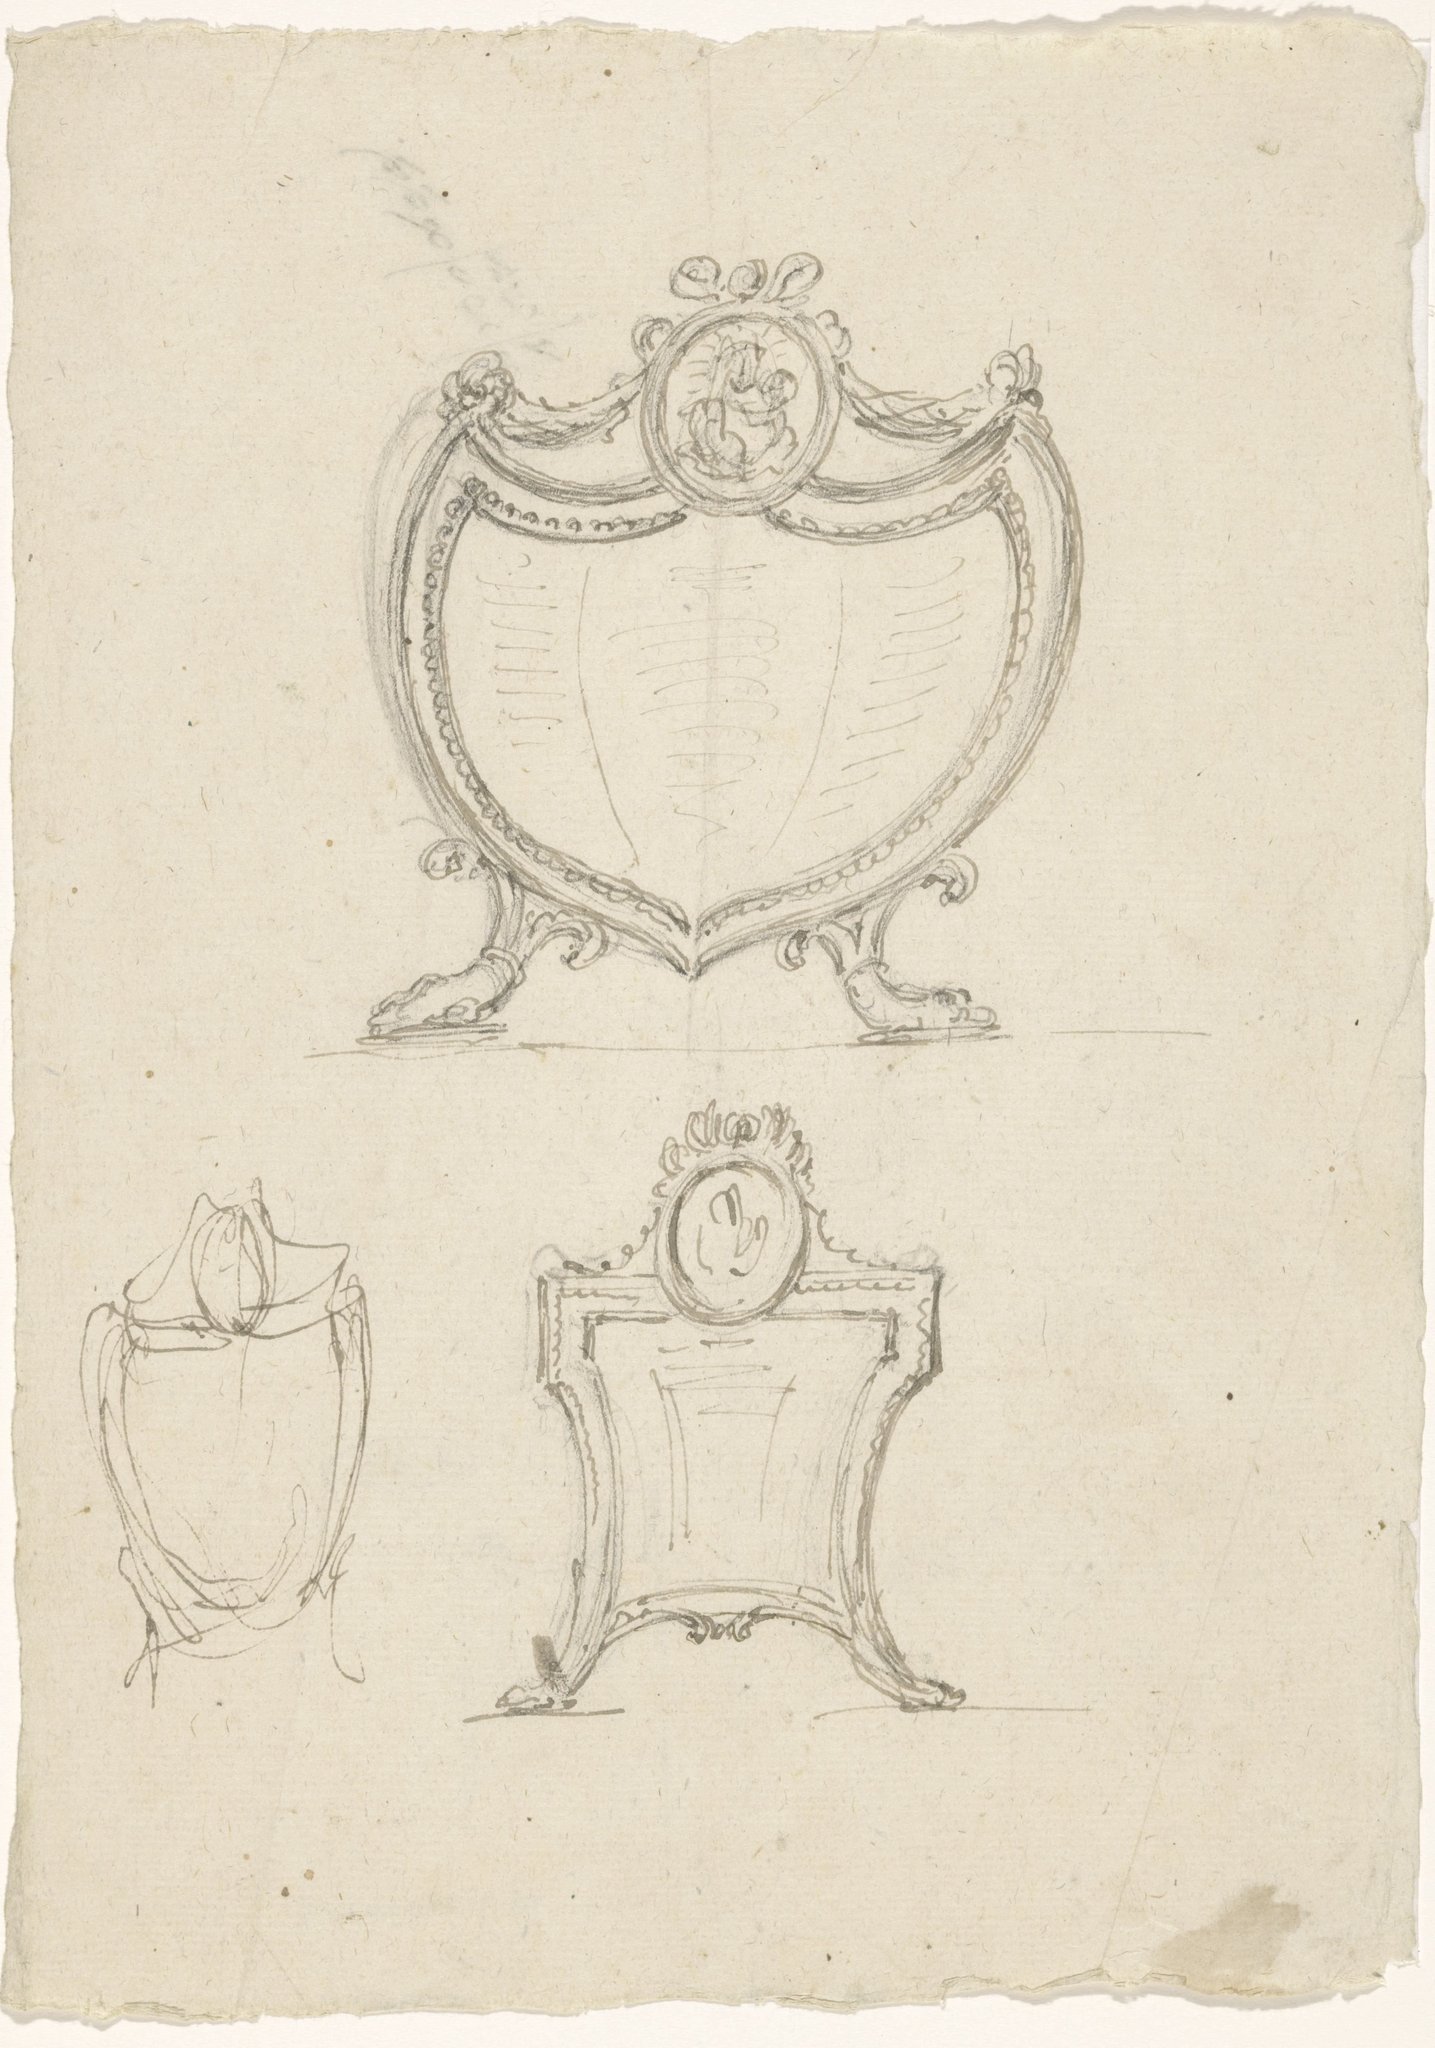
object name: design drawing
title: Ontwerp voor drie cartagloria’s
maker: luigi valadier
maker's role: draughtsman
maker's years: 1726-1785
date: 1770-1780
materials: graphite, ink, paper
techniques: pen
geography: rome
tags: altarcards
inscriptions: watermark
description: Verso: een schets van een profiel in grafiet en een optelsom in pen en bruine inkt.